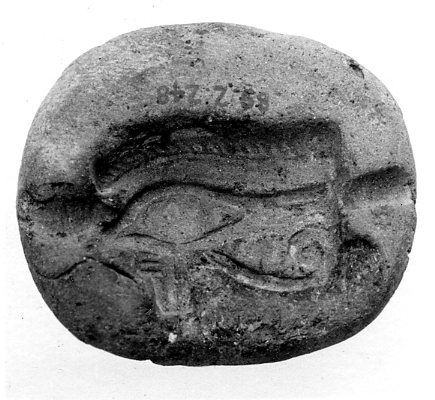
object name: mold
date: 1550-1295 BCE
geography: egypt